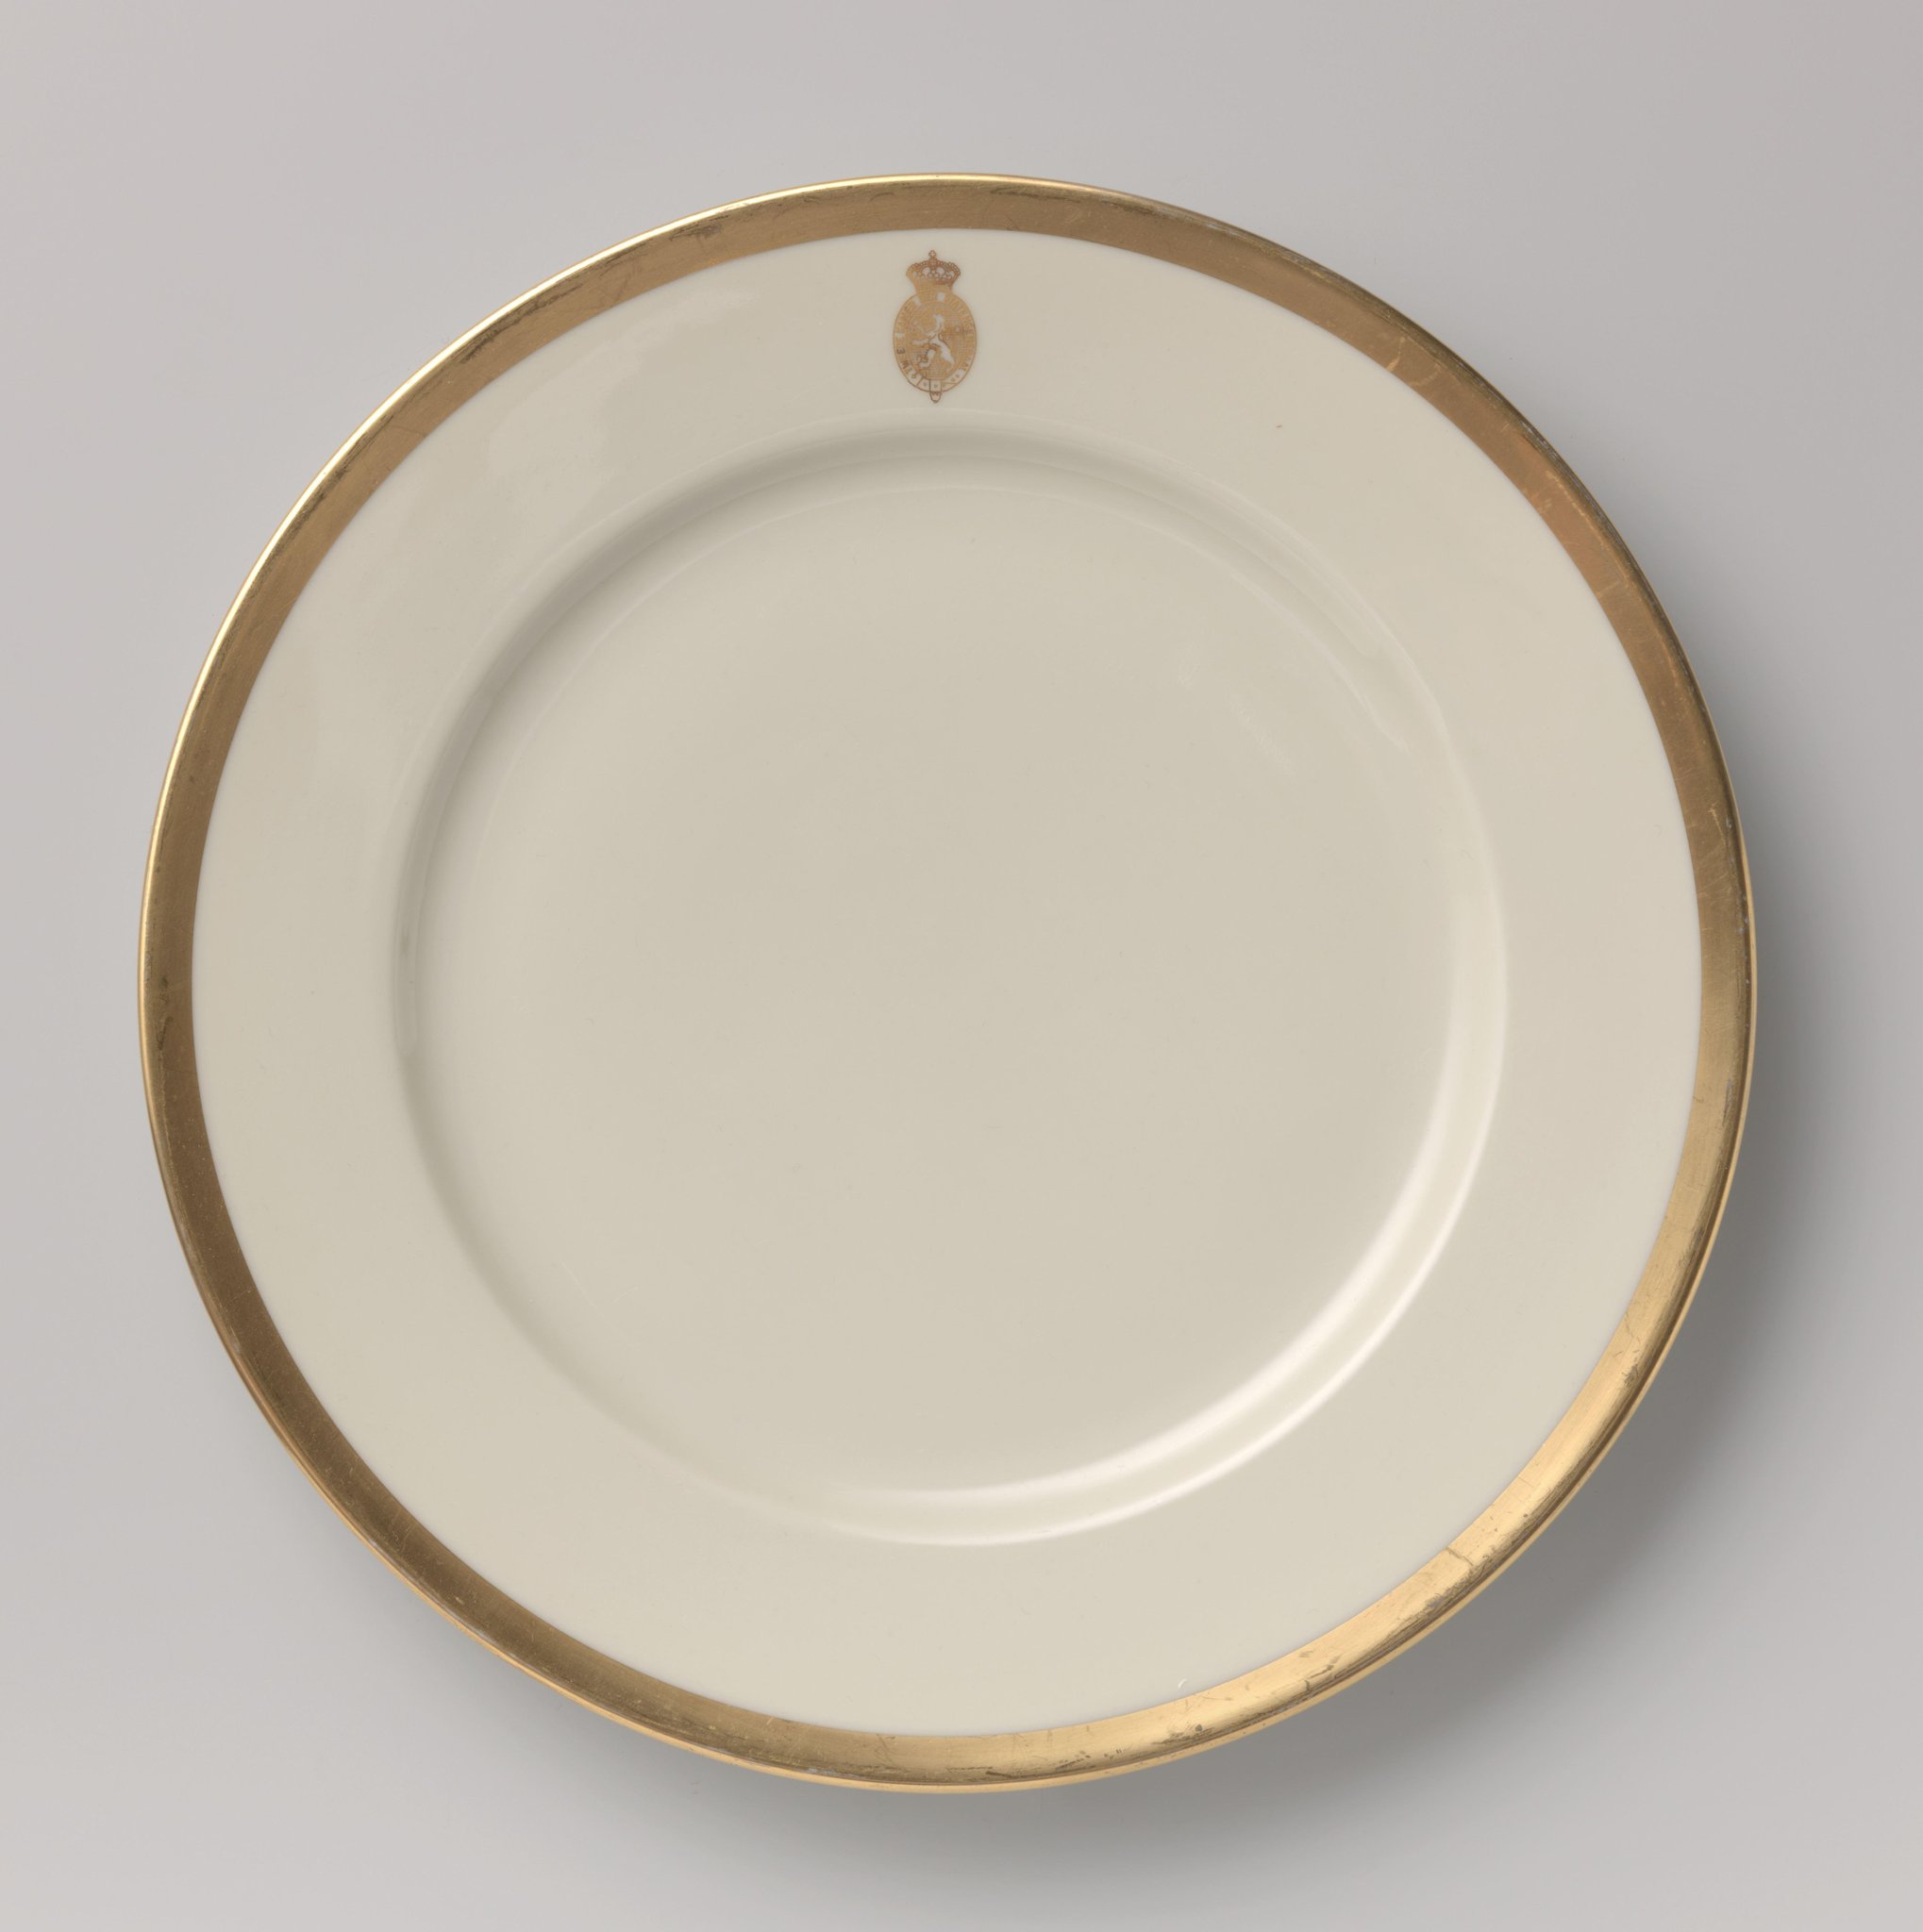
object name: plate dish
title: Plate used in the House of Representatives of the Netherlands at official receptions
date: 1900-1974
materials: glaze, gold, paint, porcelain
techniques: firing, forming, vitrification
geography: bavaria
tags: brussels, the hague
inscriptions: inscription: ‘TWEEDE KAMER DER STATENGENERAAL’, serial number: ‘Hutschenreuther Selb/ leeuw met L.H.S. Bavaria Germany/ N/ P.A.W. Philippona Den Haag/ 25’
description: Bord van porselein, beschilderd op het glazuur in goud. Versierd met een gouden rand en het gekroonde wapen van de Tweede Kamer met het opschrift 'TWEEDE KAMER DER STATENGENERAAL'. Gemerkt op de onderzijde met het fabrieksmerk, 'P.A.W. PHILIPPONA DEN HAAG', N en 25. Mogelijk gedecoreerd in Den Haag.